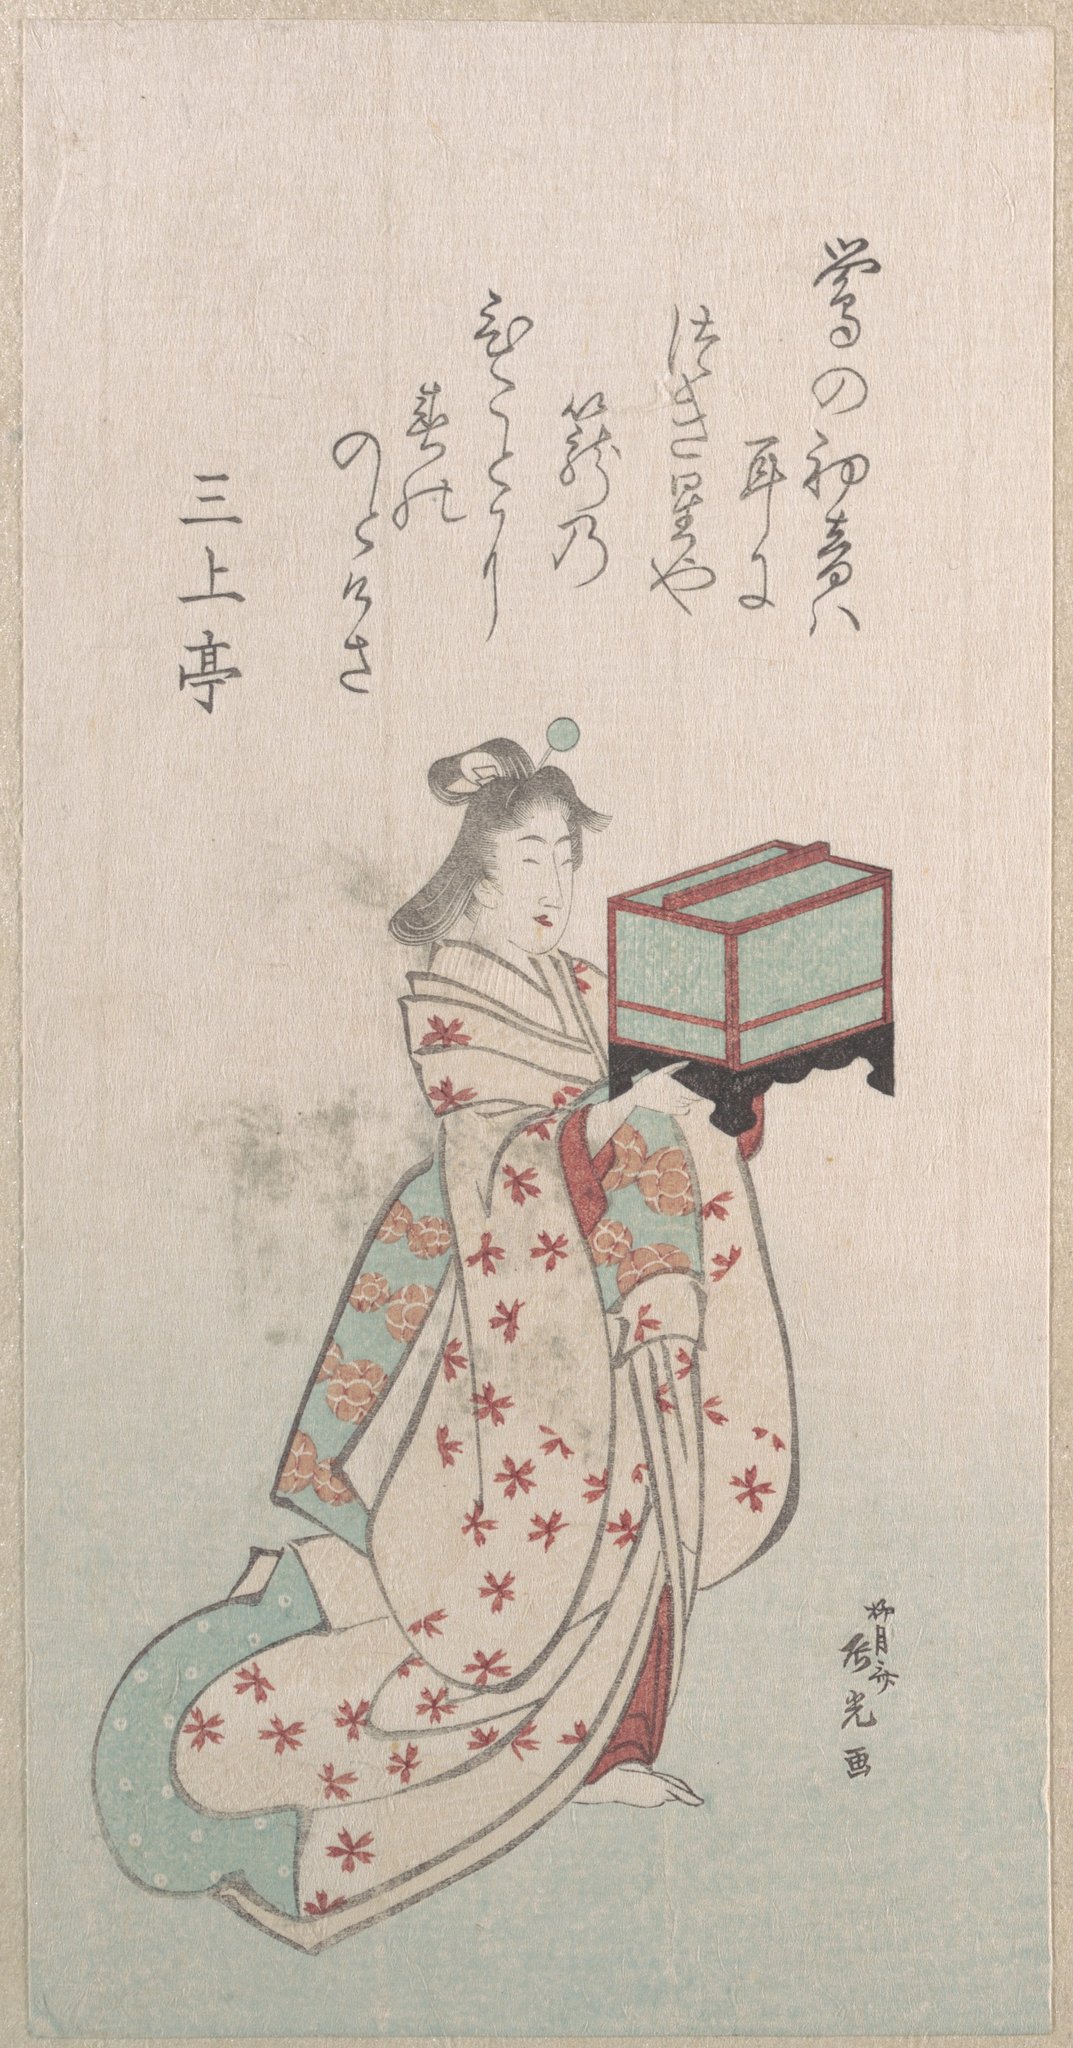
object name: print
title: Spring Rain Collection (Harusame shū), vol. 2: Young Woman with a Birdcage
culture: japanese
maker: ryūgetsusai shinkō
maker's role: artist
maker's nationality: japanese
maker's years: 1810-1819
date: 1810-1819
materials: ink, paper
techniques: surimono, woodblock print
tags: women